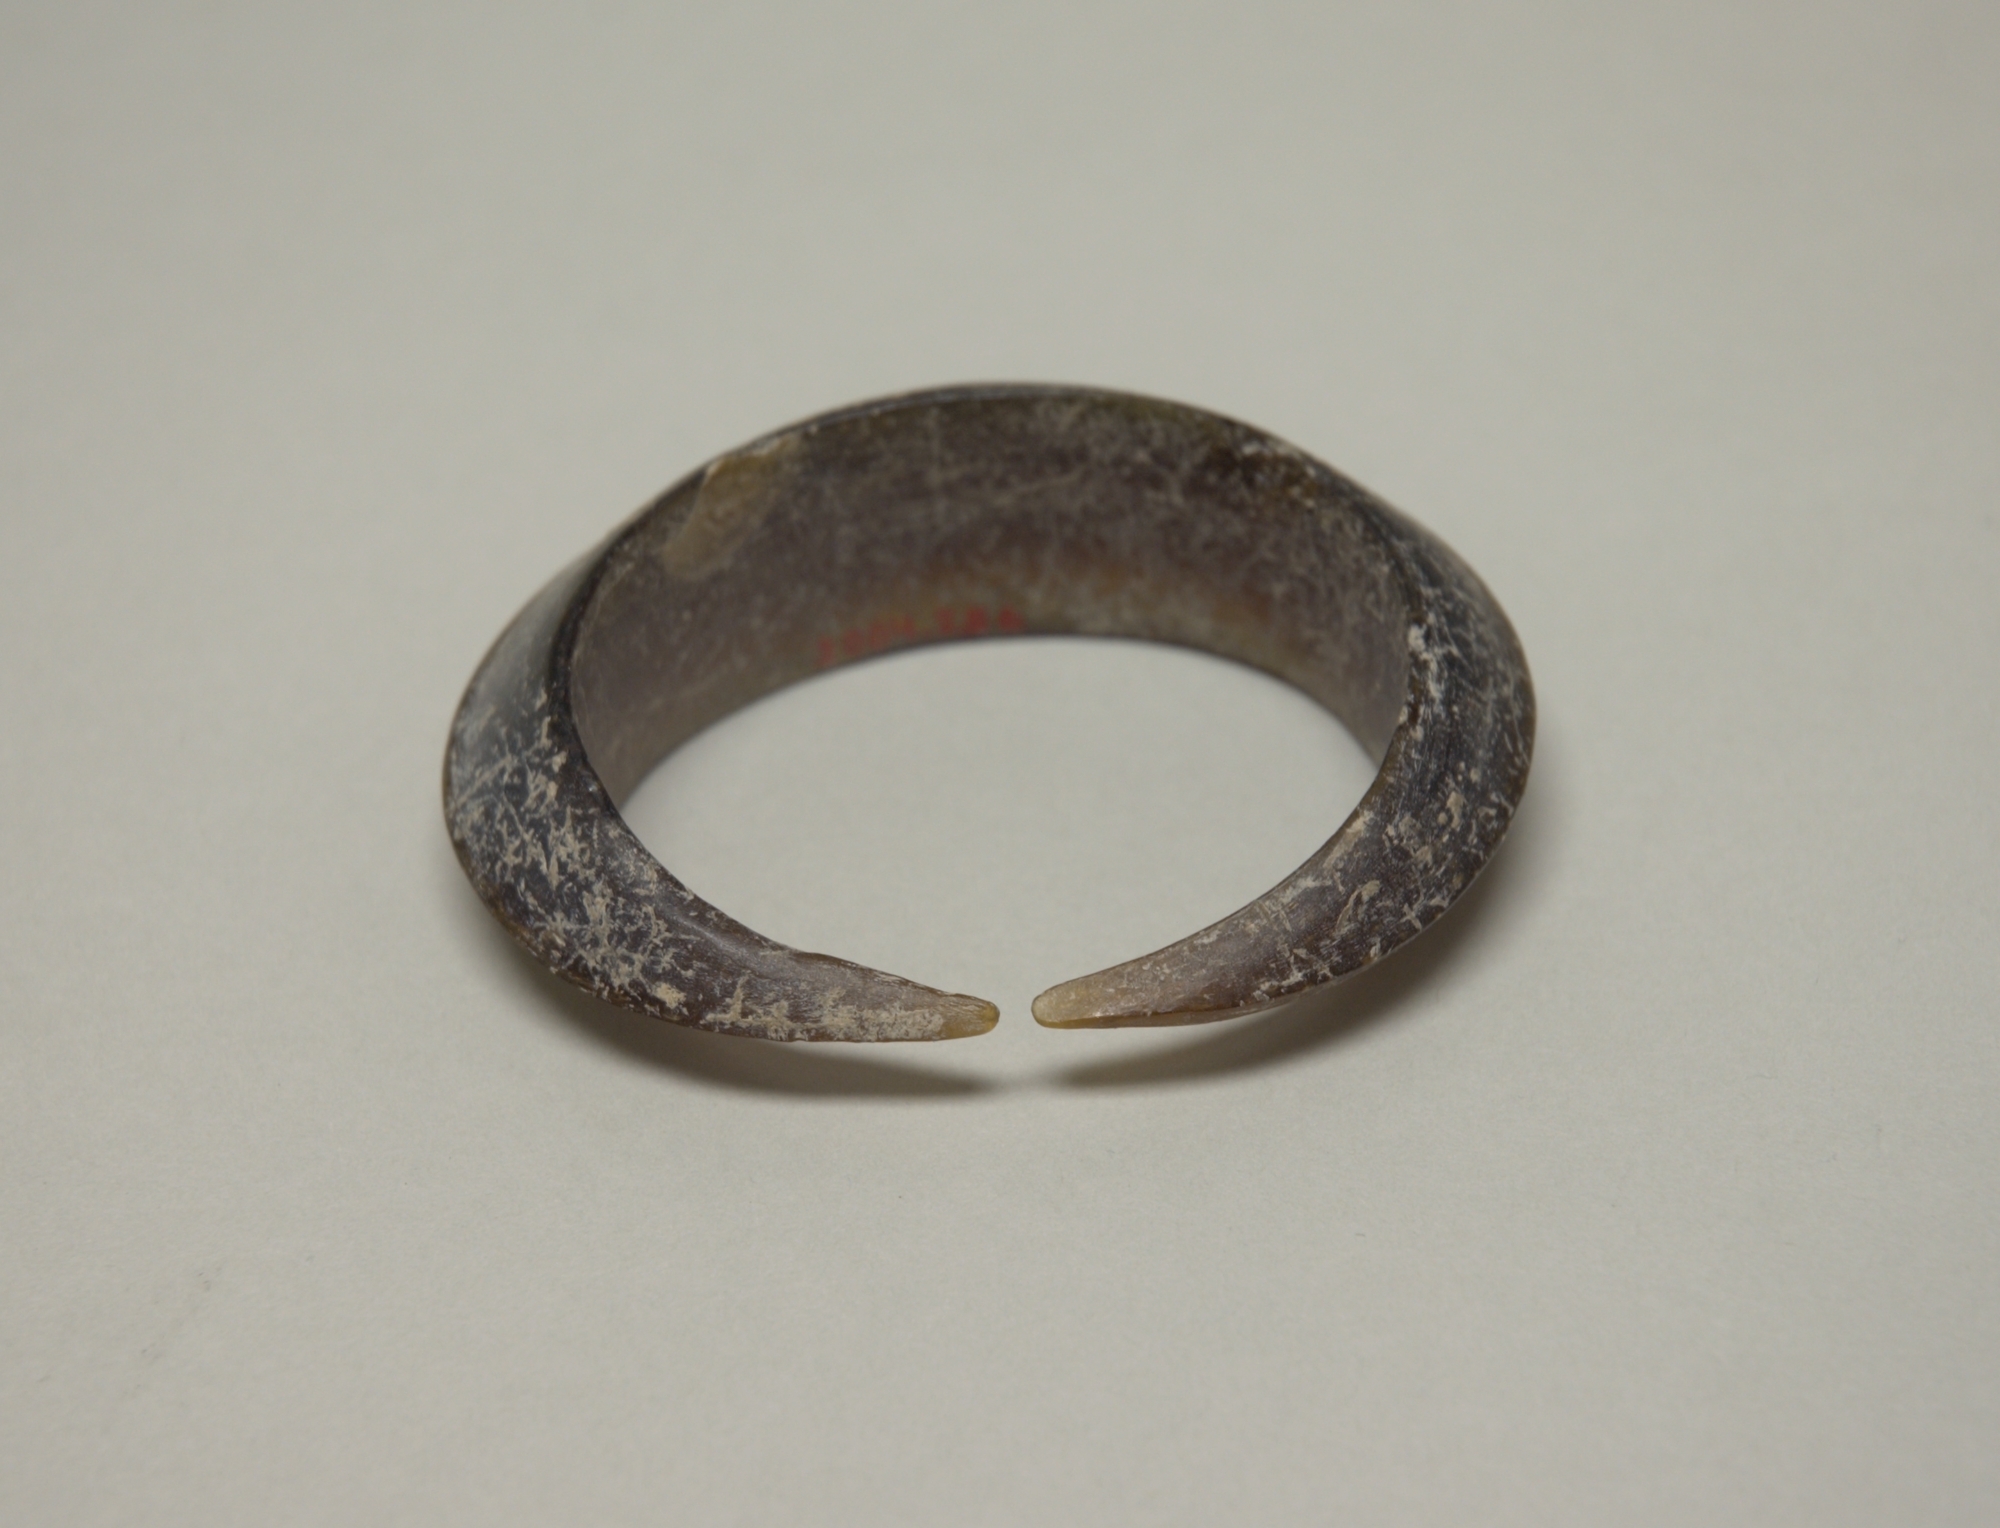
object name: earring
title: Large Closed Crescent-Shaped Earring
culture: vietnamese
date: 500 BCE-300 CE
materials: glass